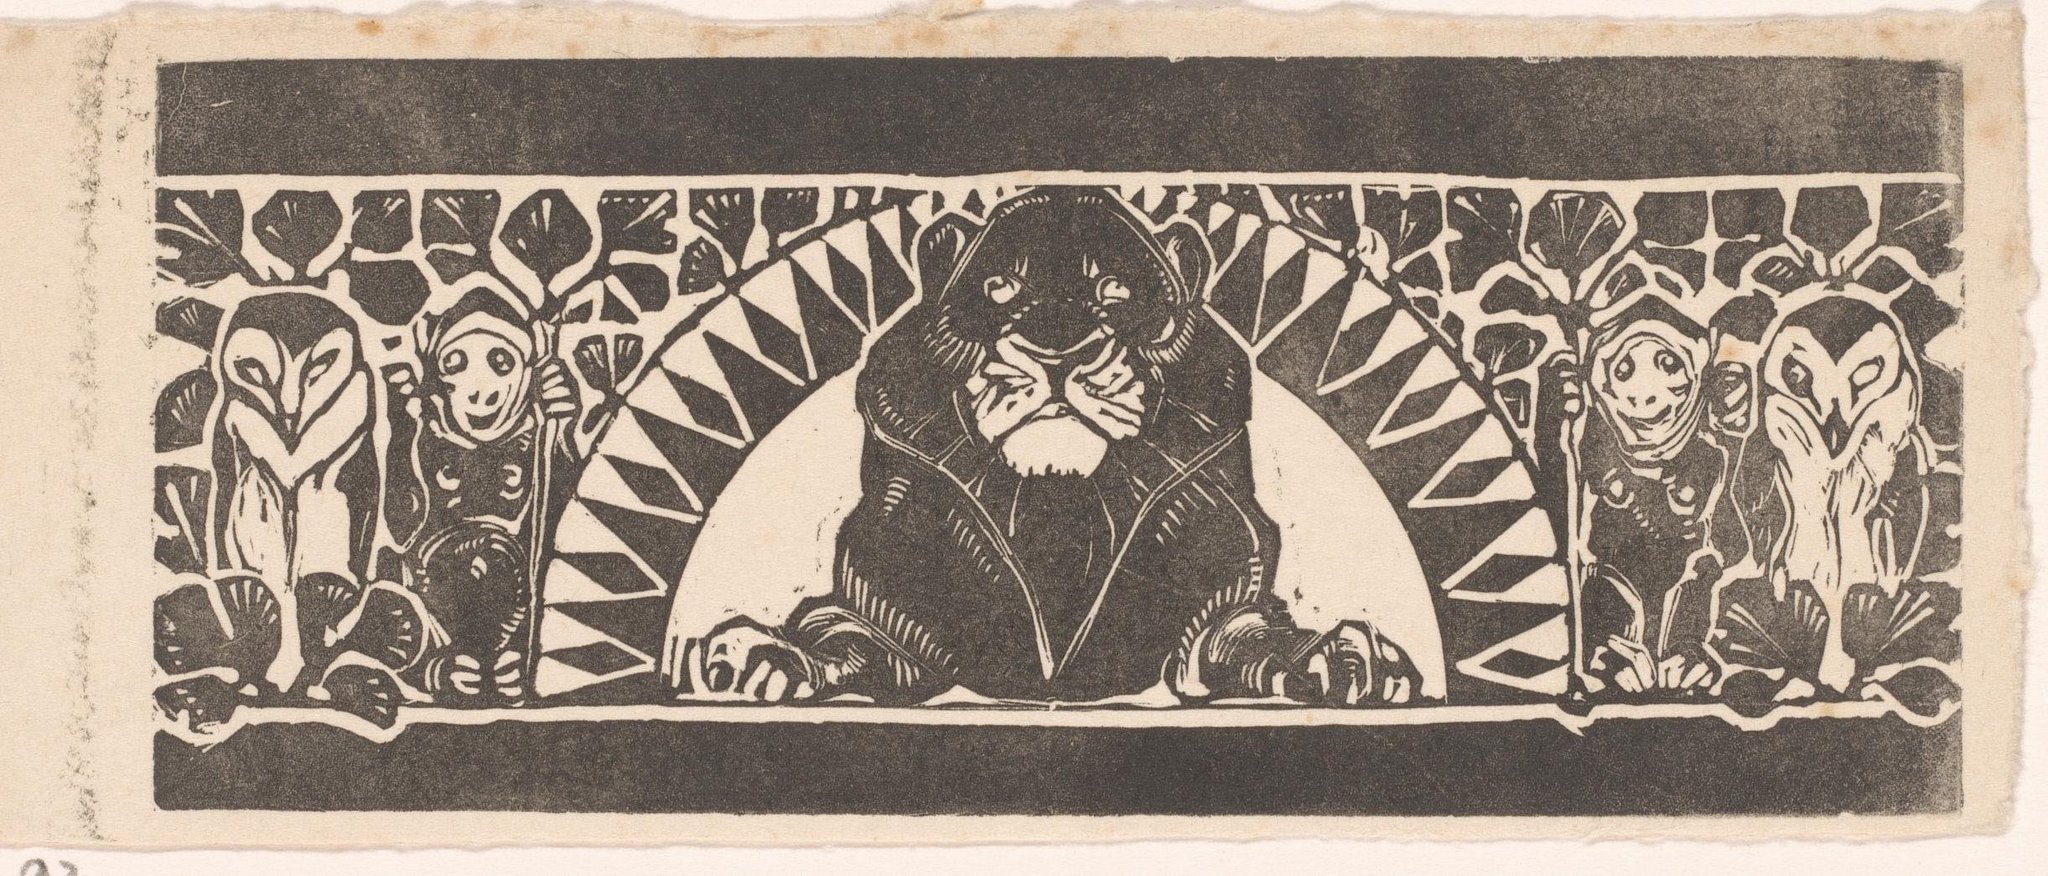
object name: boekillustratie ontwerp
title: Leeuw, uilen en apen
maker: bernard willem wierink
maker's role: draughtsman, print maker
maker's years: 1856-1939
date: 1910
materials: paper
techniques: relief print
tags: lion's head ~ ornament, monkeys, apes, owls, fable of reynard the fox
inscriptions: collector's mark: Lugt 2228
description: Ontwerp voor: Streuvels, Stijn (Frank Lateur). Reinaert de Vos naar verschillende uitgaven van het middeleeuwsche epos. Amsterdam: L.J. Veen, 1910. Deze prent is vermoedelijk een plaatsnede, ook al wordt in de literatuur veelal gesproken over een houtsnede. Voor zover Wierink zijn prenten in hoogdruk zelf nader heeft omschreven, heeft hij altijd de term 'plaatsnede' gebruikt.